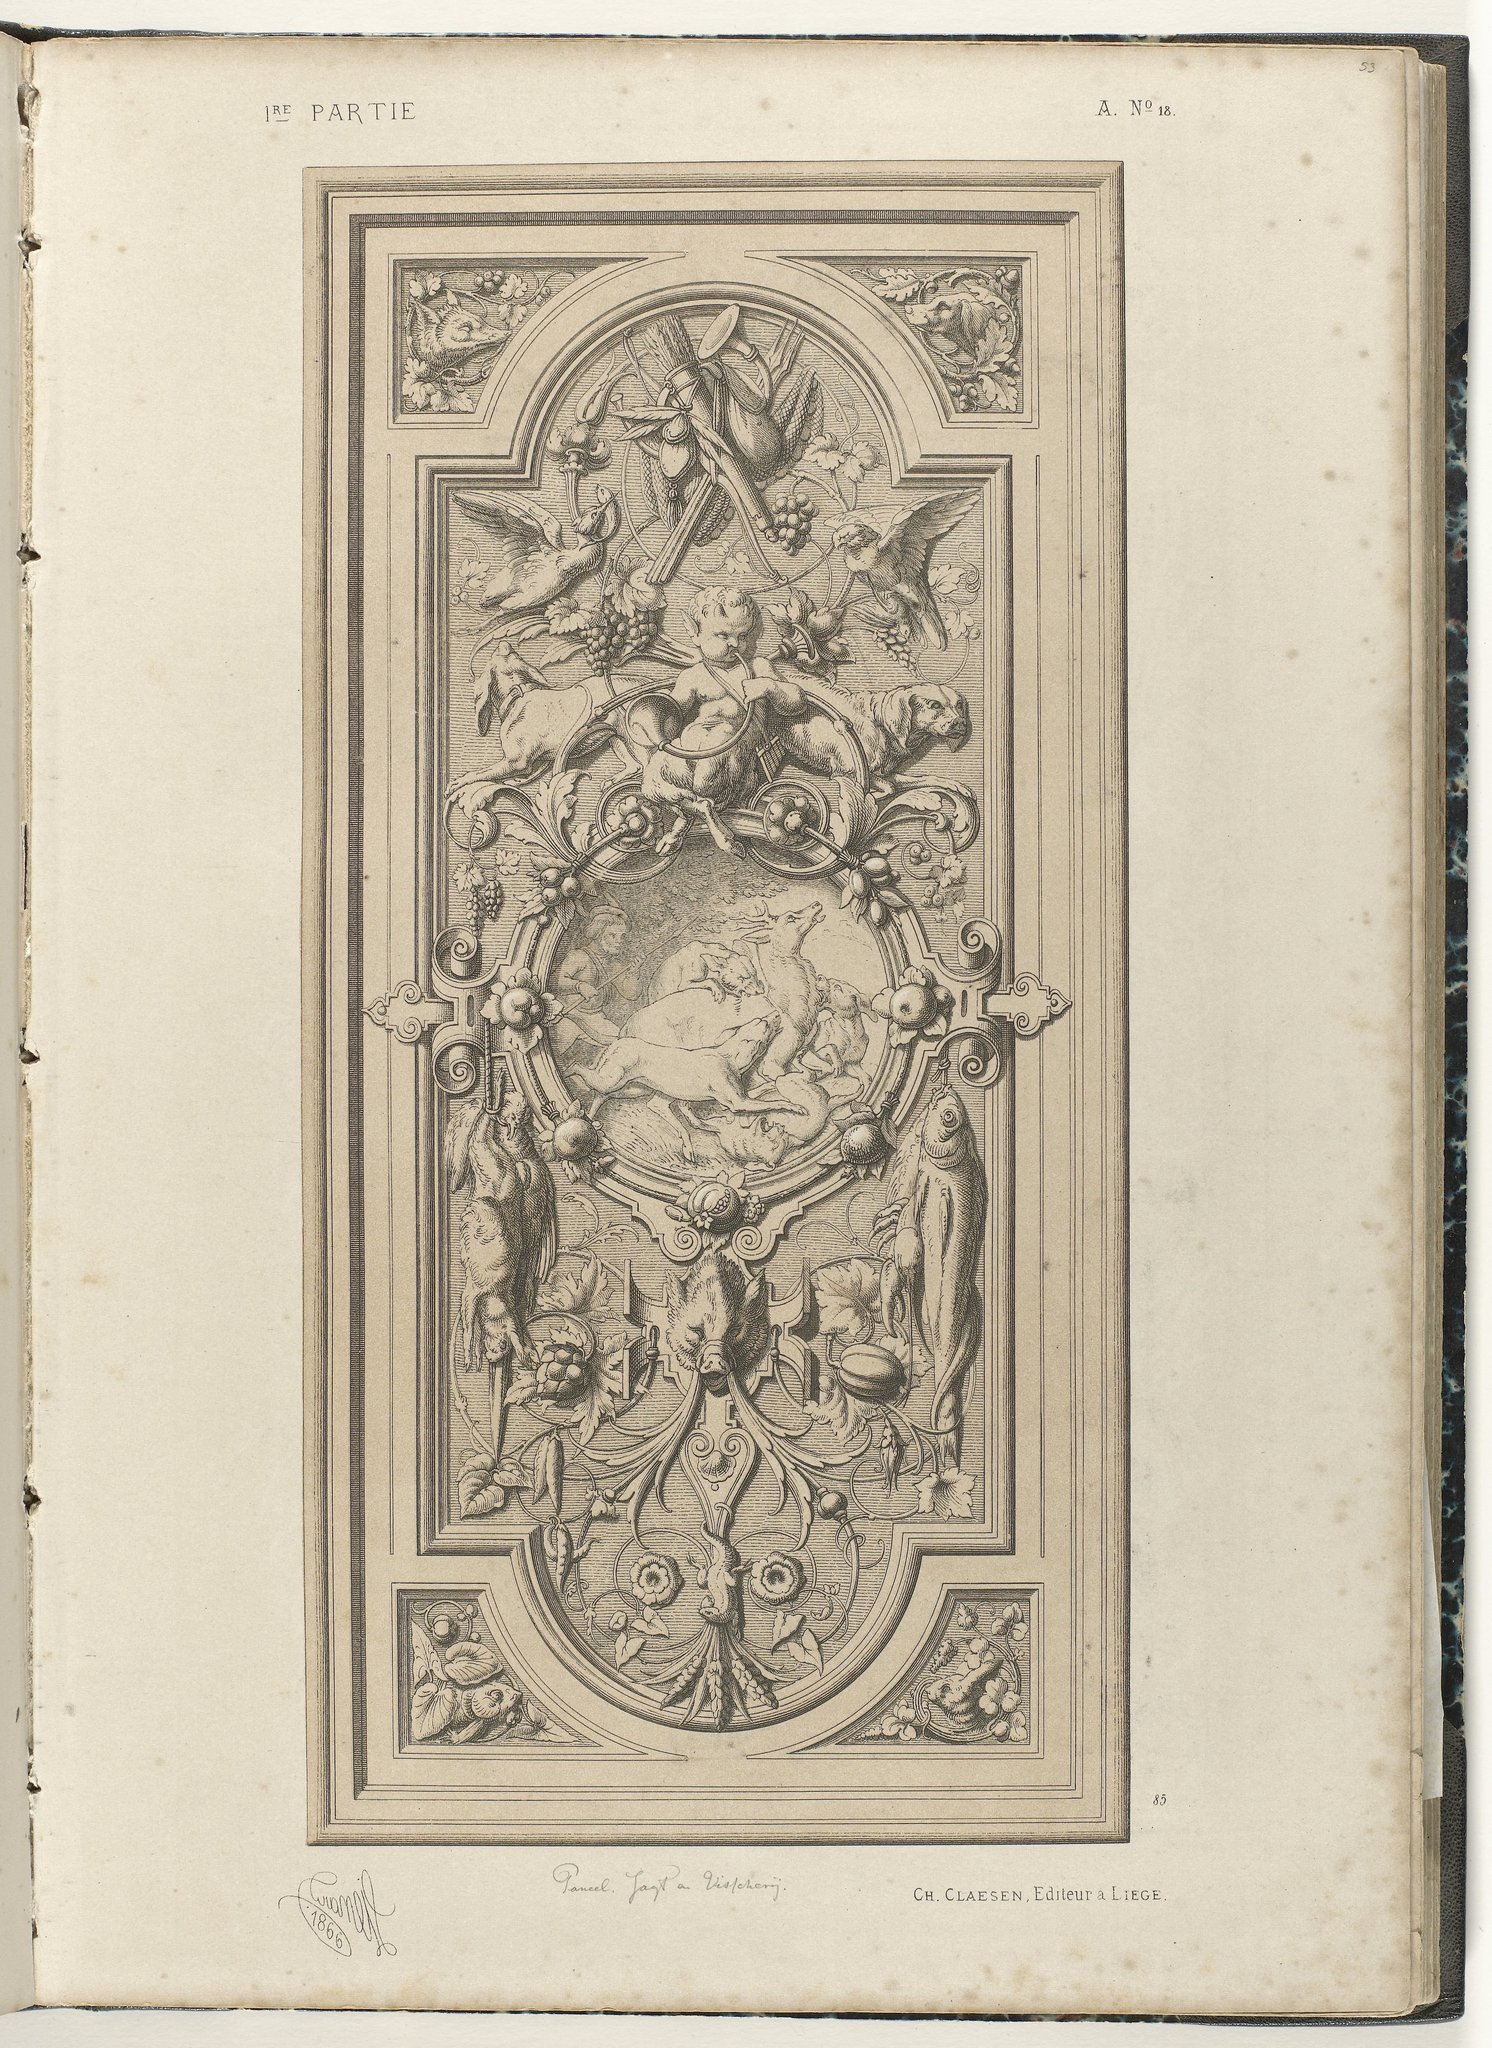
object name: print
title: Paneel met jachtscène in cartouche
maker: michel liénard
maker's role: print maker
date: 1866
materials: paper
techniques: tone lithography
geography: liège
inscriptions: annotation: ‘Paneel, Jagt en Visscherij.’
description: Onderaan de cartouche hangt de kop van een everzwijn. Linksboven staat: 1re partie, rechtsboven: A. N° 18., rechtsonder: 85.